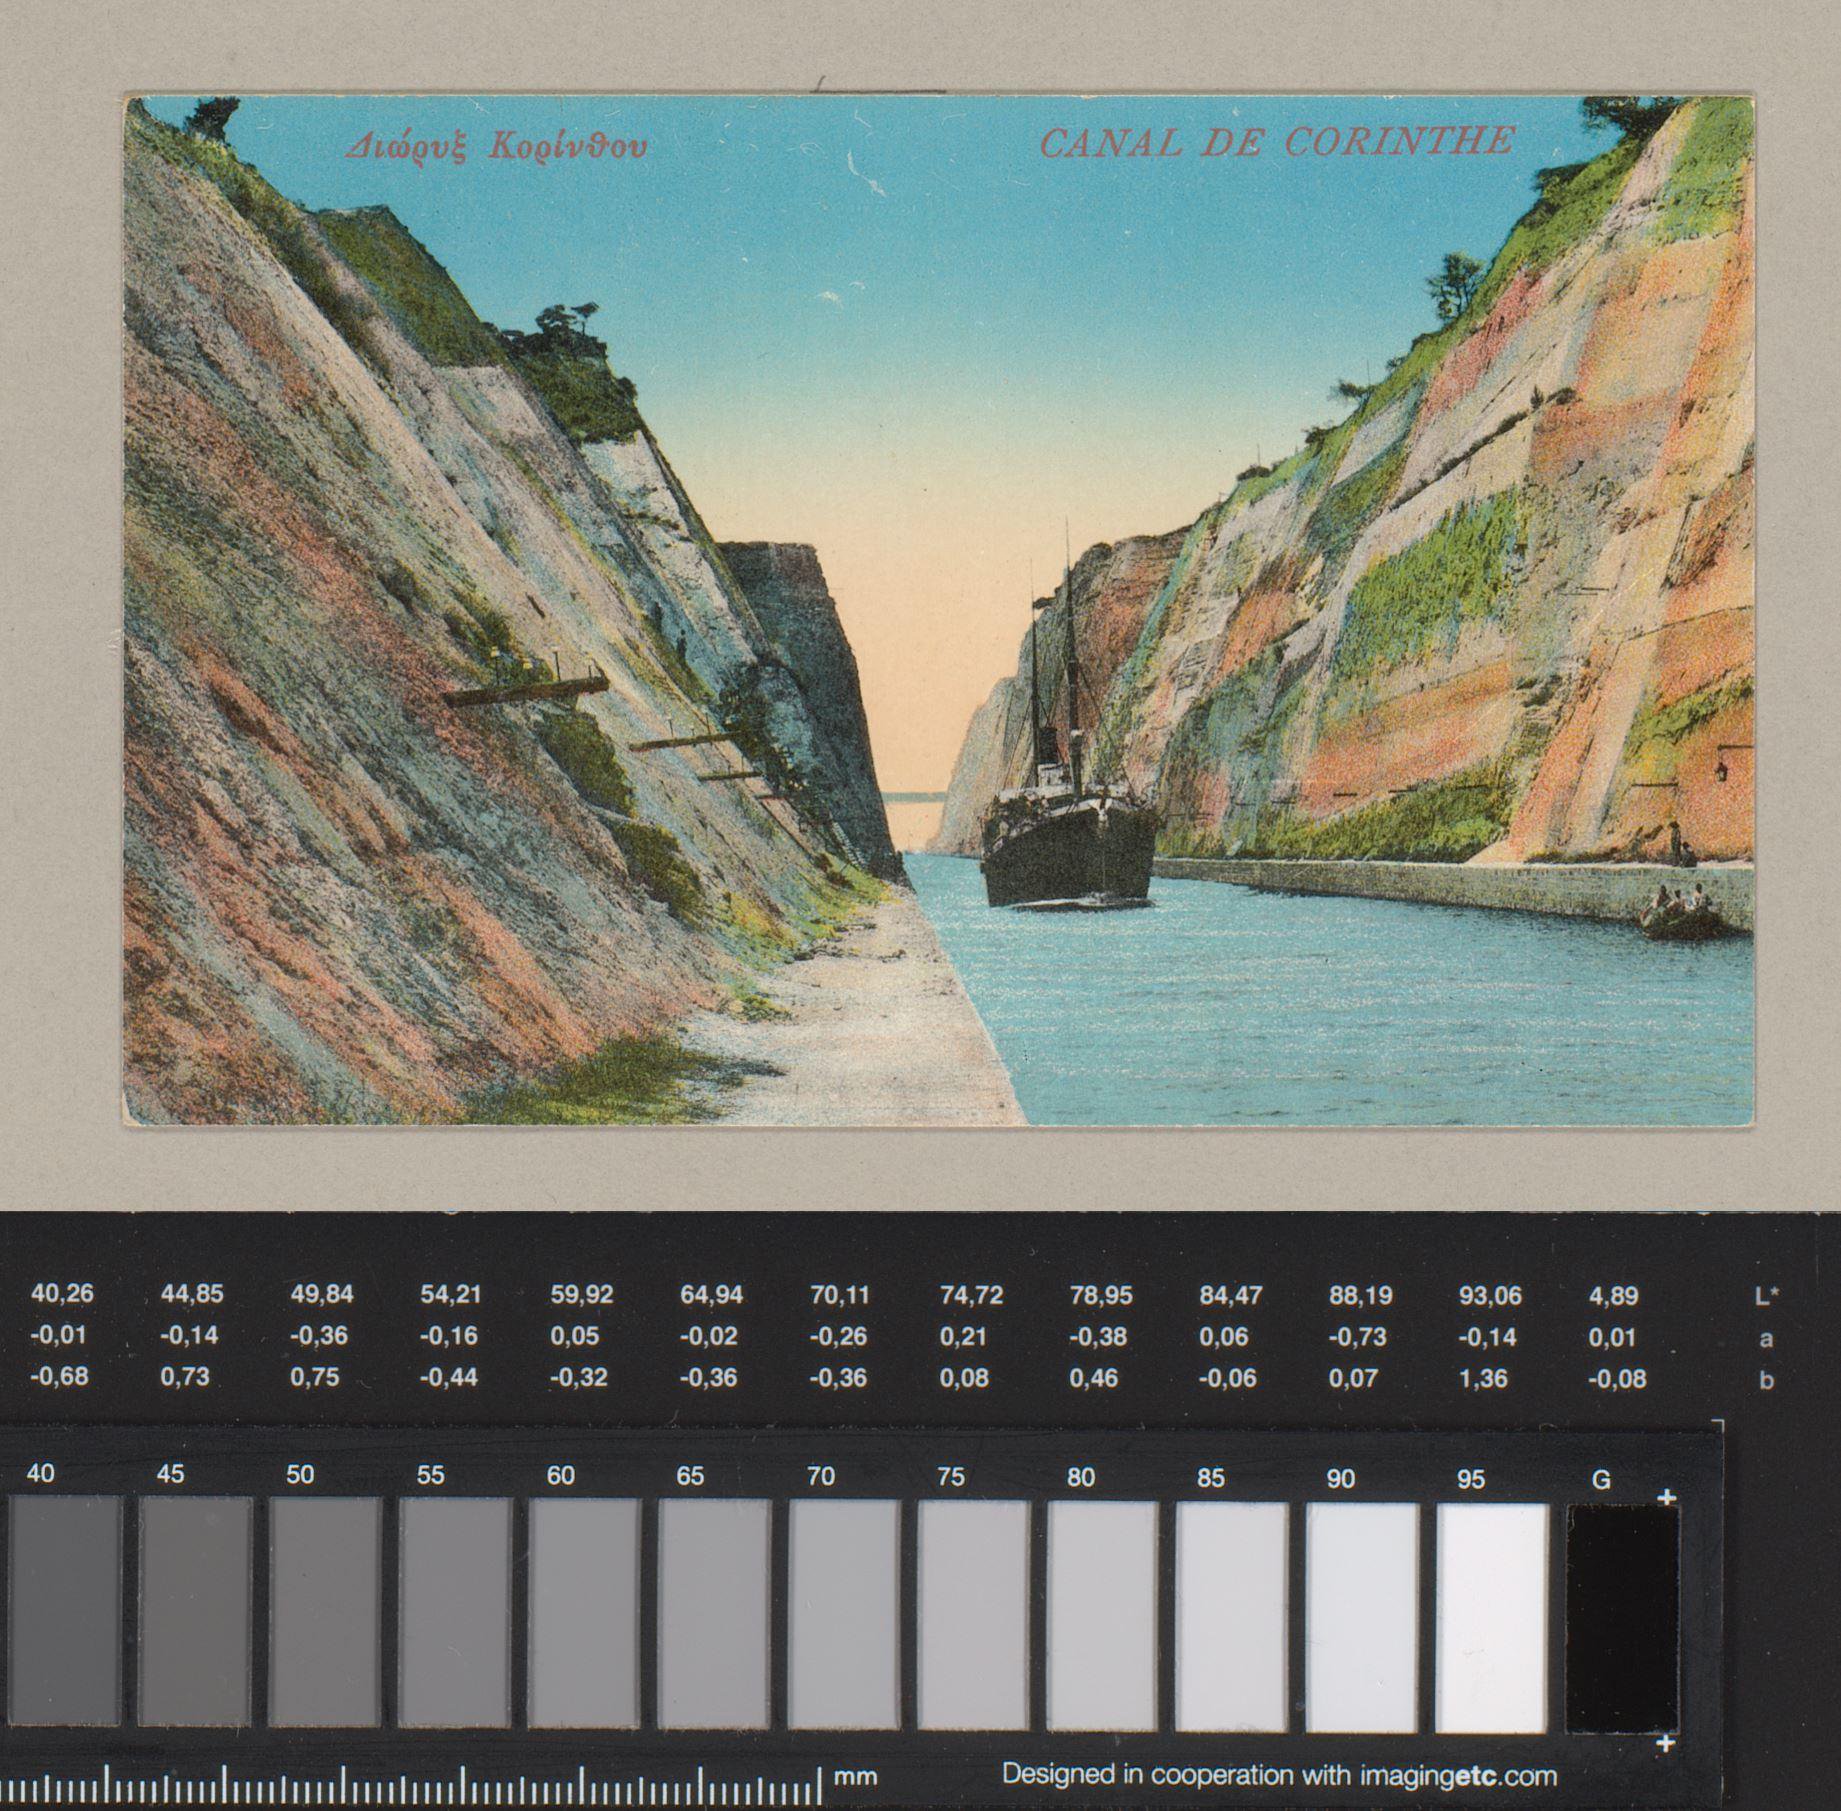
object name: ansichtkaart, prentbriefkaart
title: Canal de Corinthe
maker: Anonymous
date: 1895-1915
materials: cardboard, paper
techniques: lithograph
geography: greece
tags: griekenland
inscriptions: annotation: ‘5. Verwoeste Byzantijnsche Stad, Mistra.’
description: In het midden van het kanaal vaart een schip. Linksboven staat een titel in het Grieks (?).